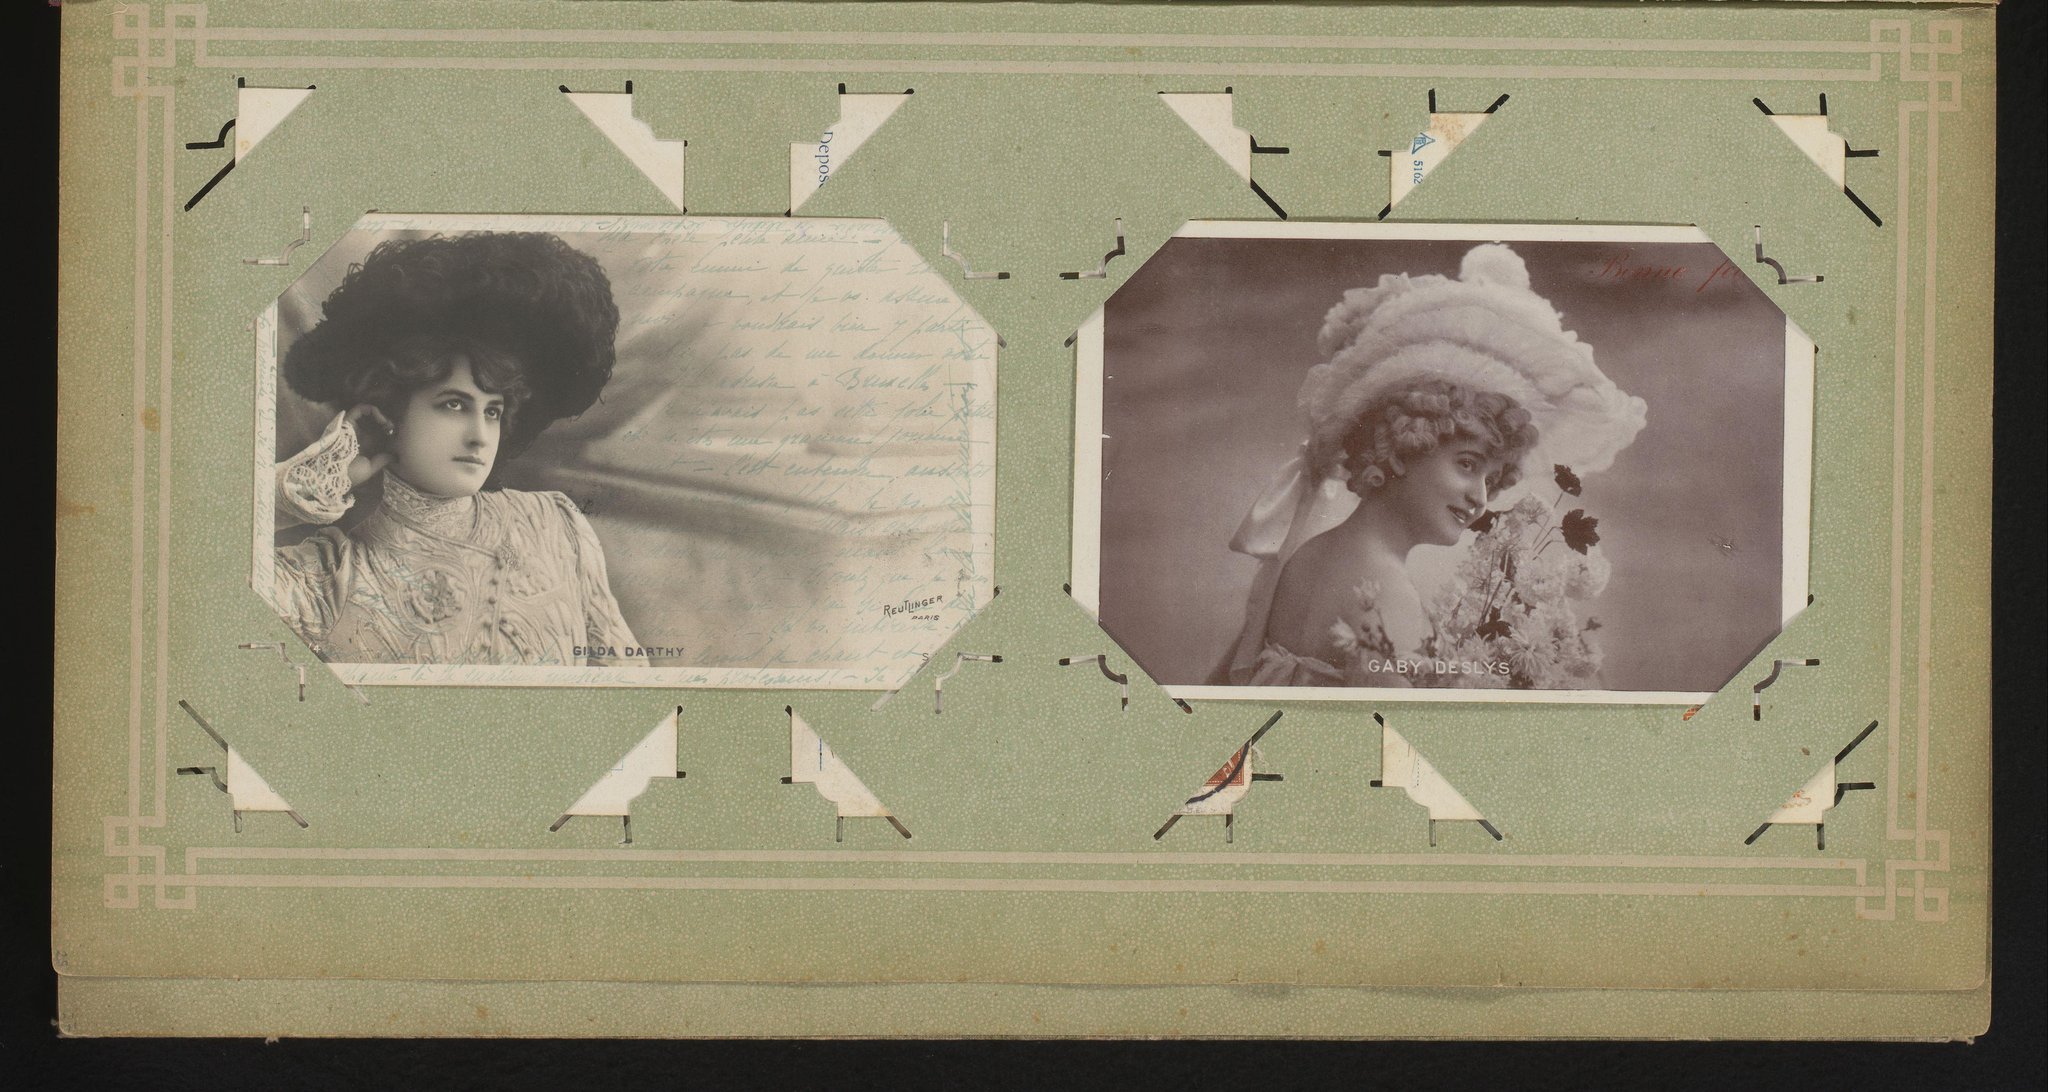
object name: photomechanical print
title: Twee portretten van Gilda Darthy en Gaby Deslys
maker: Anonymous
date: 1900-1930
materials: cardboard, ink, photographic support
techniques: gelatin silver print, pen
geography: paris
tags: paris, historical persons - bb - woman, portrait of actor, actress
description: Deze foto en prent maken deel uit van een album.